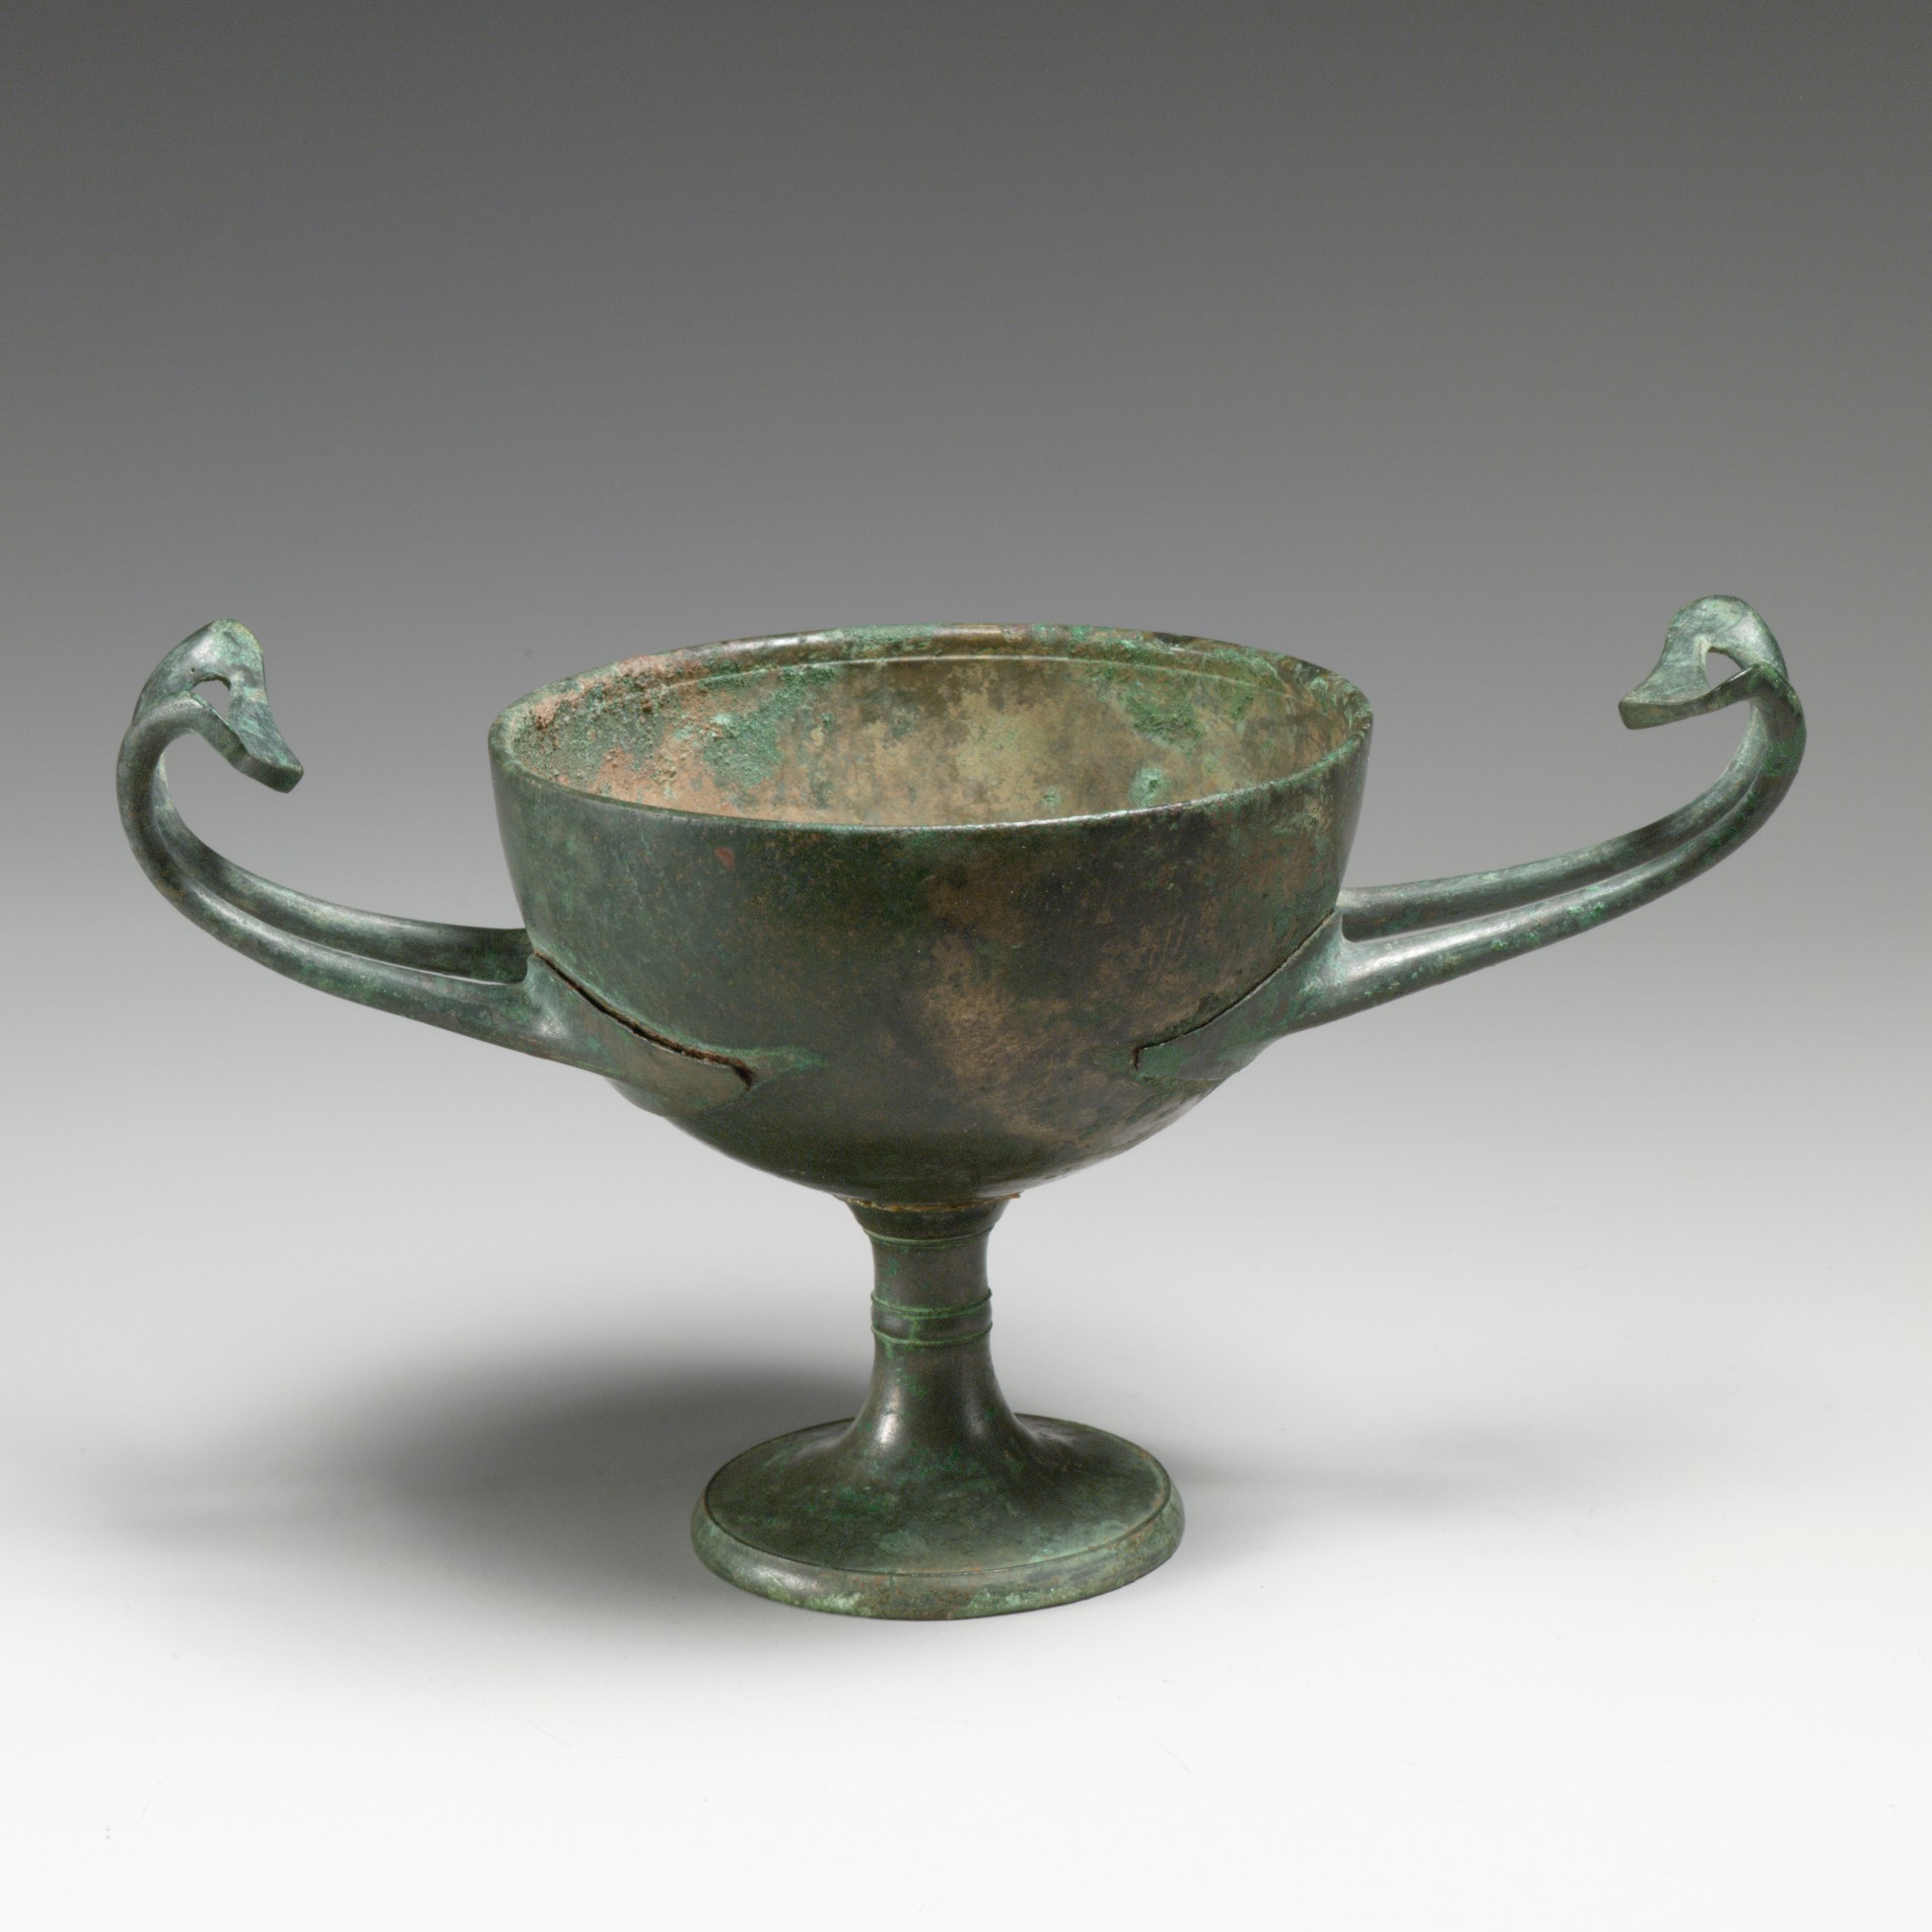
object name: kylix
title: Bronze kylix (drinking cup)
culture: greek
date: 400-201 BCE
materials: bronze